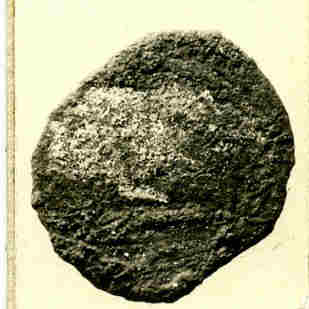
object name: coin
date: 701-900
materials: copper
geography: iran